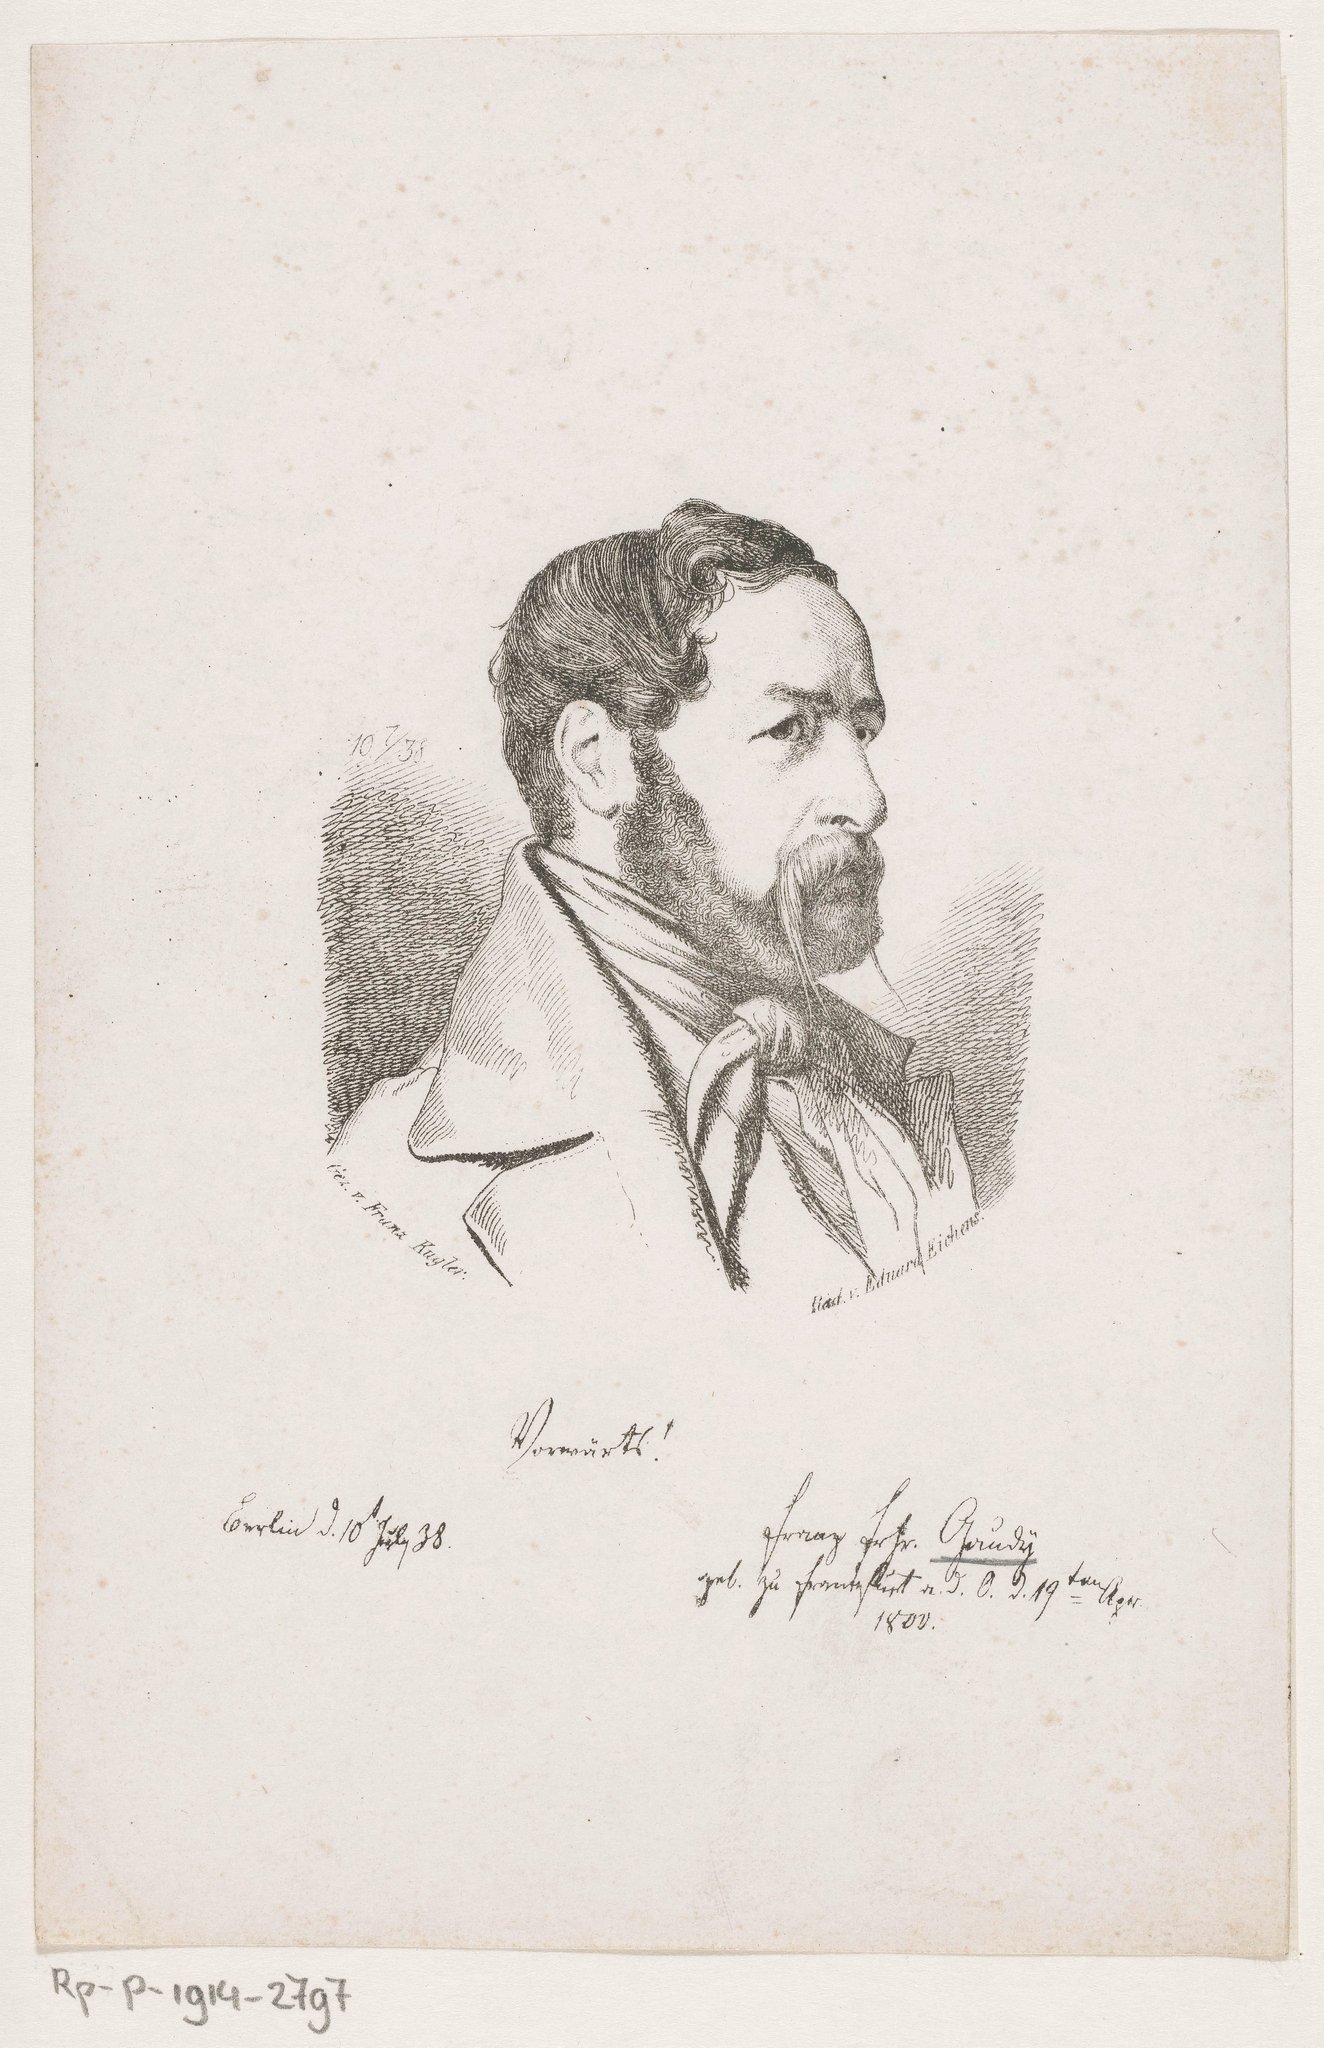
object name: print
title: Portret van Franz van Gaudy op 38-jarige leeftijd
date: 1838-1877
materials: paper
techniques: etching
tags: berlin, moustache, historical persons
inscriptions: collector's mark: Lugt 2228